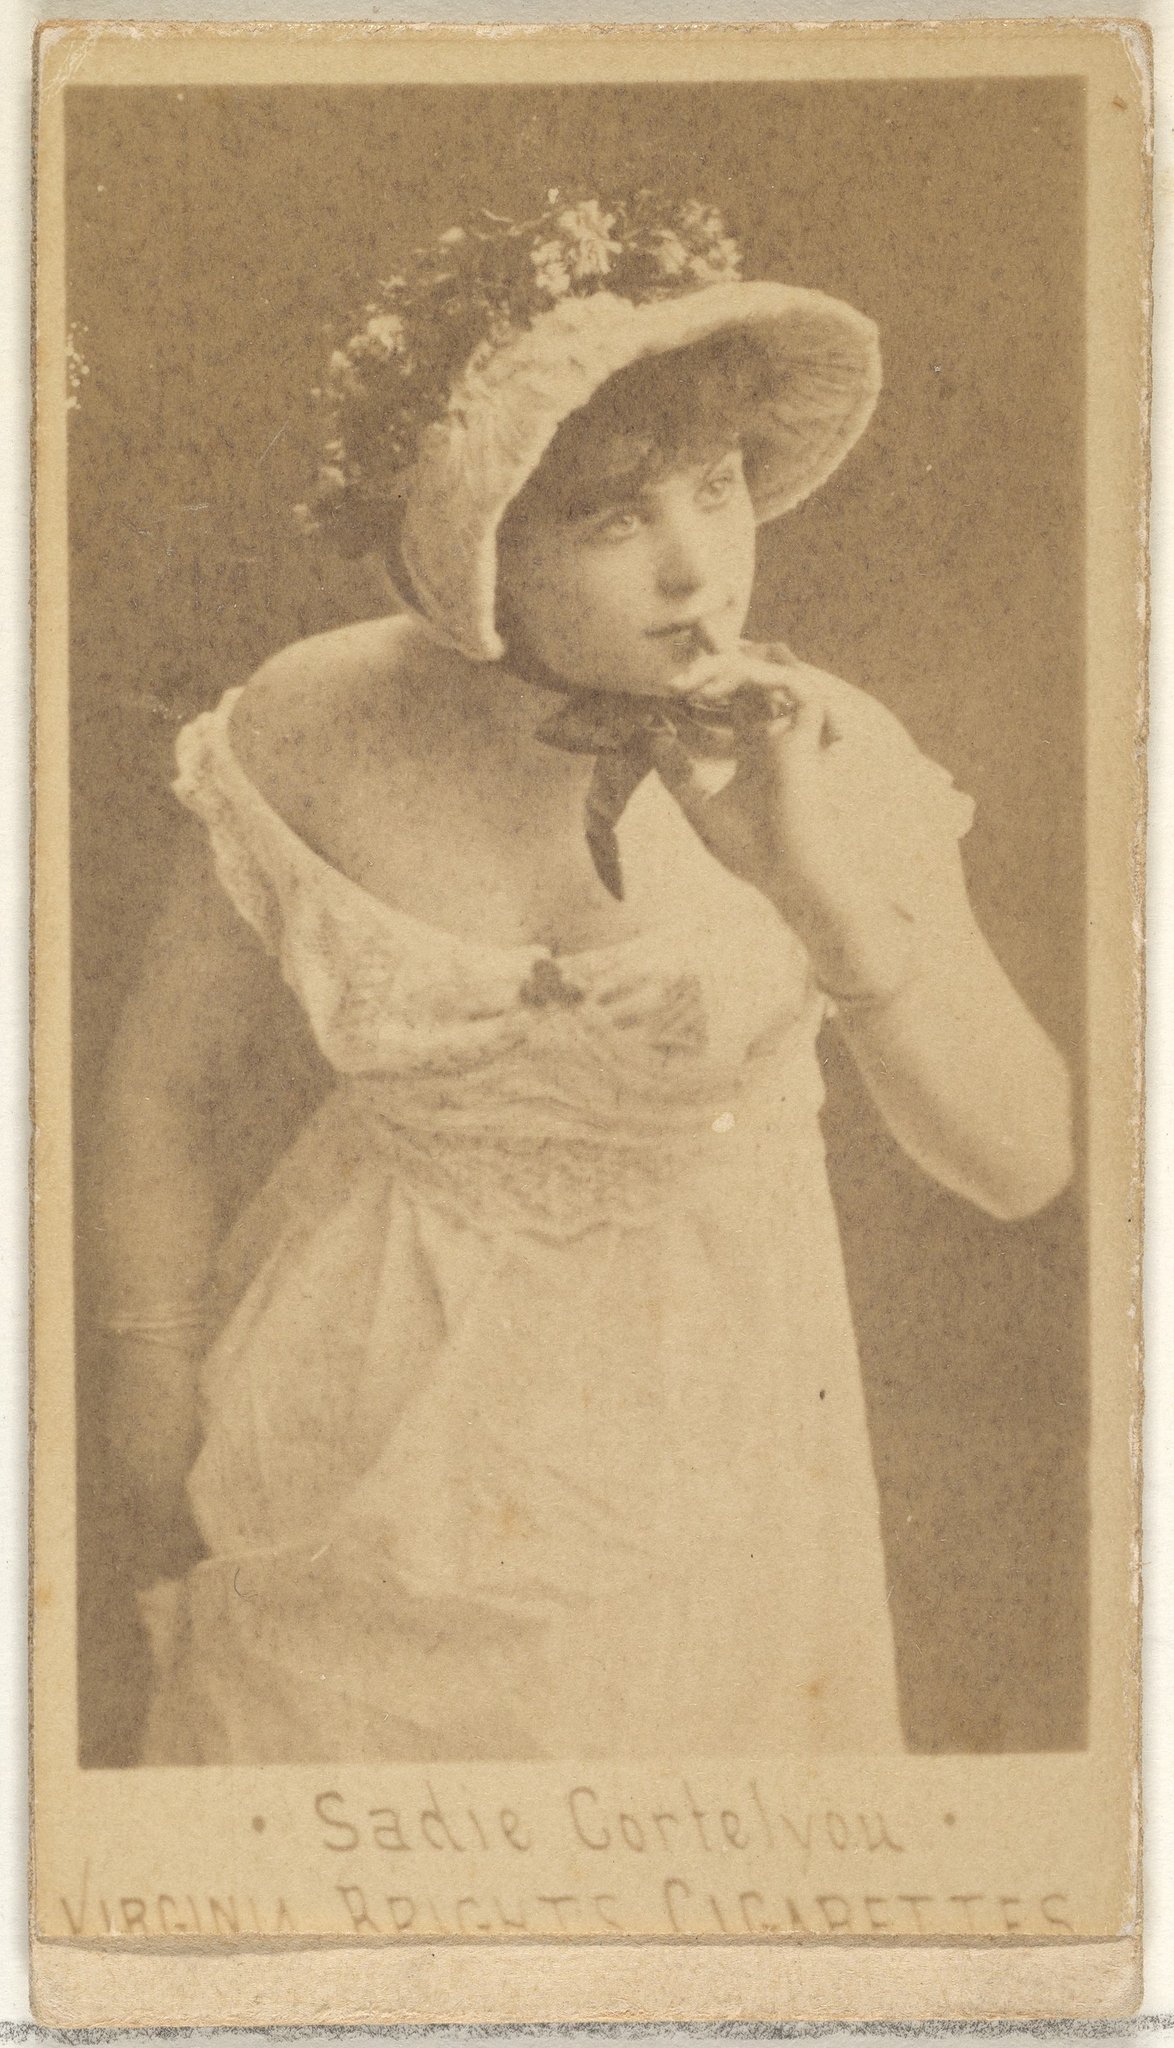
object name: photograph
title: Sadie Cortelyou, from the Actors and Actresses series (N45, Type 1) for Virginia Brights Cigarettes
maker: allen & ginter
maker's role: publisher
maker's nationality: american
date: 1888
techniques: albumen silver print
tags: portraits,women,actresses